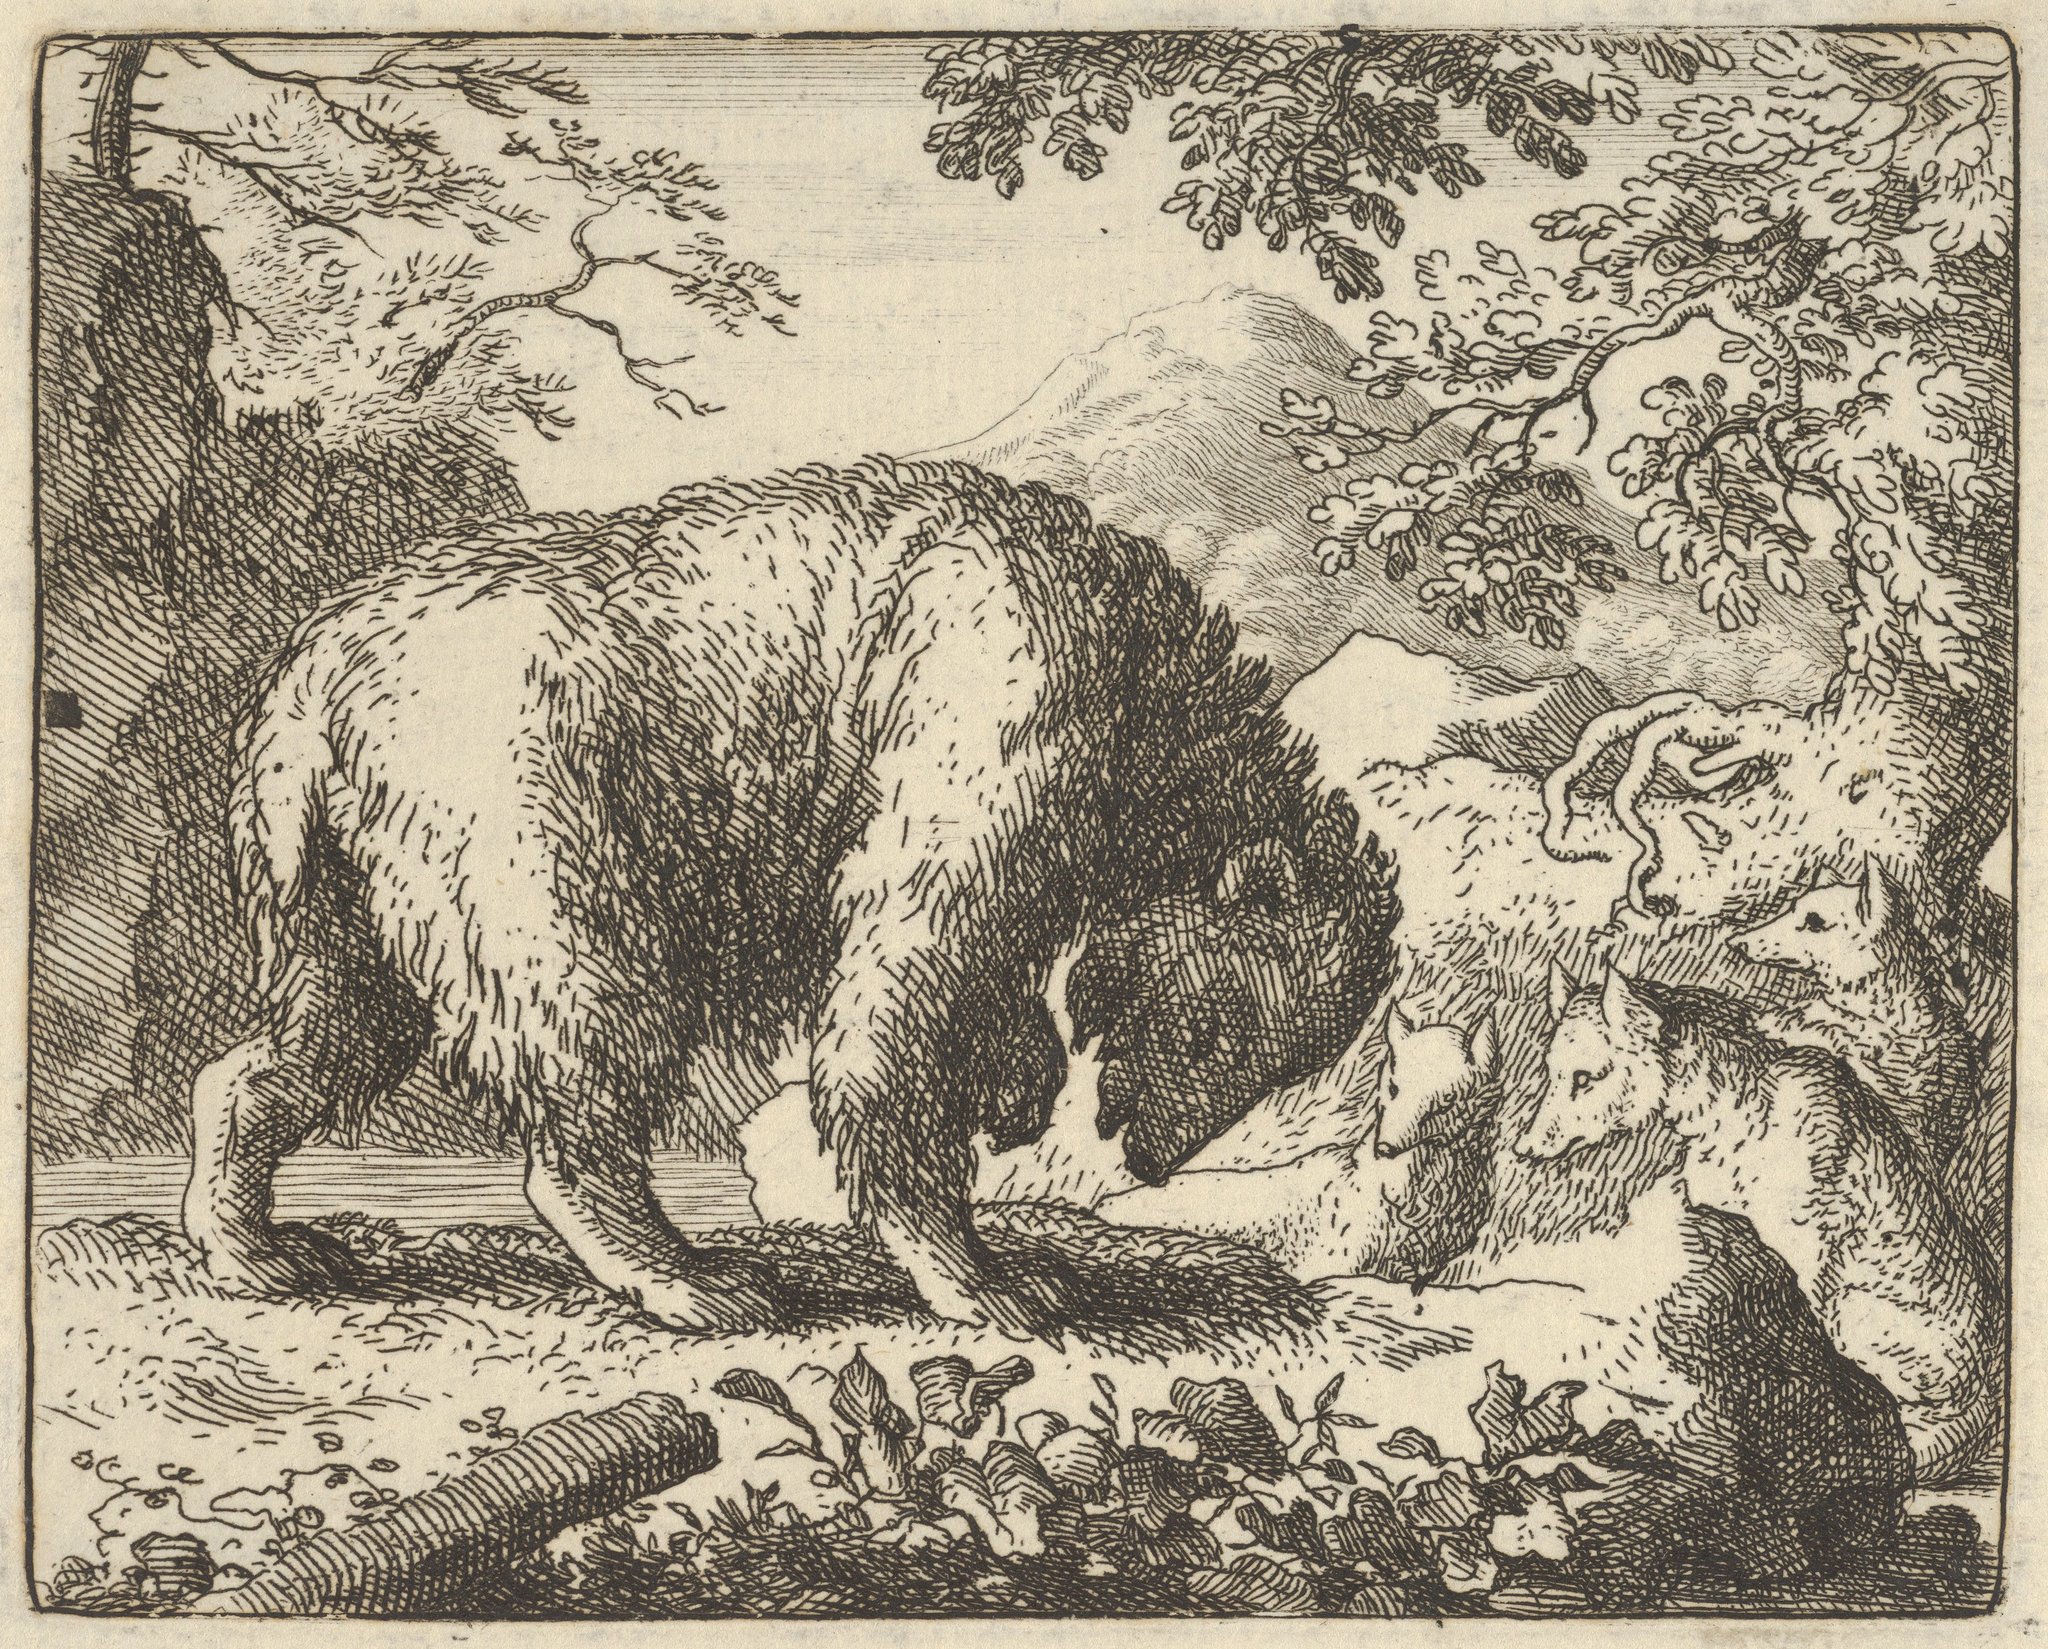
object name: print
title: Renard Promises the Bear to Take Him to a Place Where He Will Find Honey from Hendrick van Alcmar's Renard The Fox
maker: allart van everdingen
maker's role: artist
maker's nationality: dutch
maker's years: 1621-1675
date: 1650-1675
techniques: engraving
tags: bears,foxes